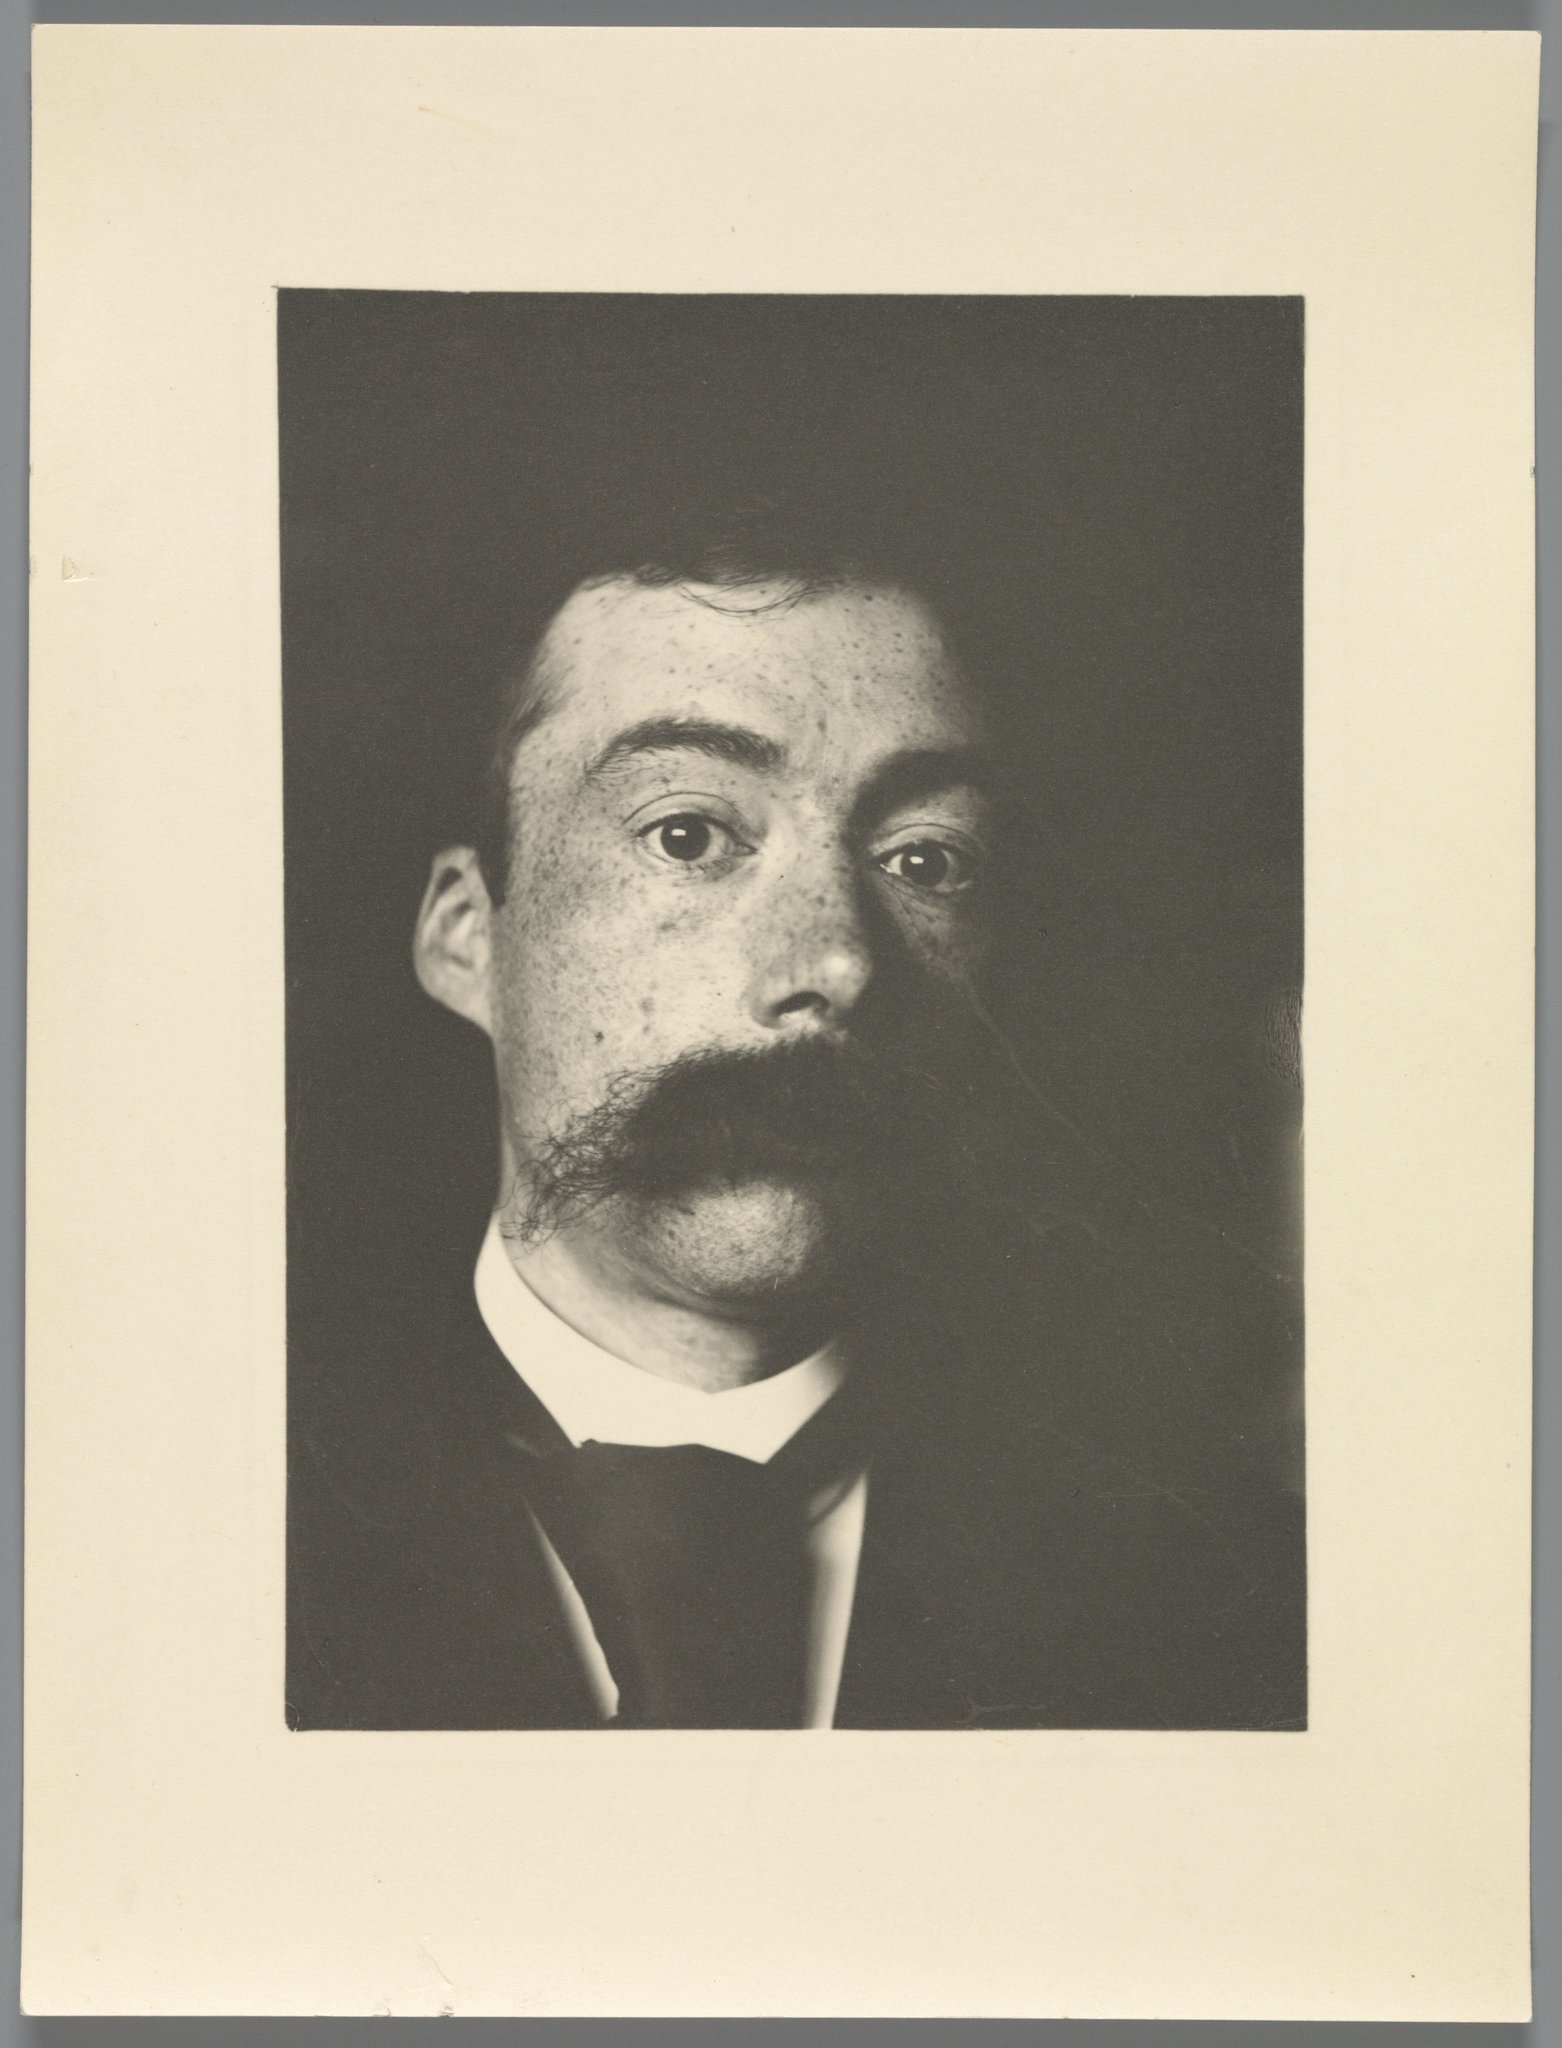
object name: photograph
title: Reproductie naar een foto van Willem Witsen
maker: Anonymous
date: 1860-1915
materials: paper, photographic support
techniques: gelatin silver print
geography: netherlands